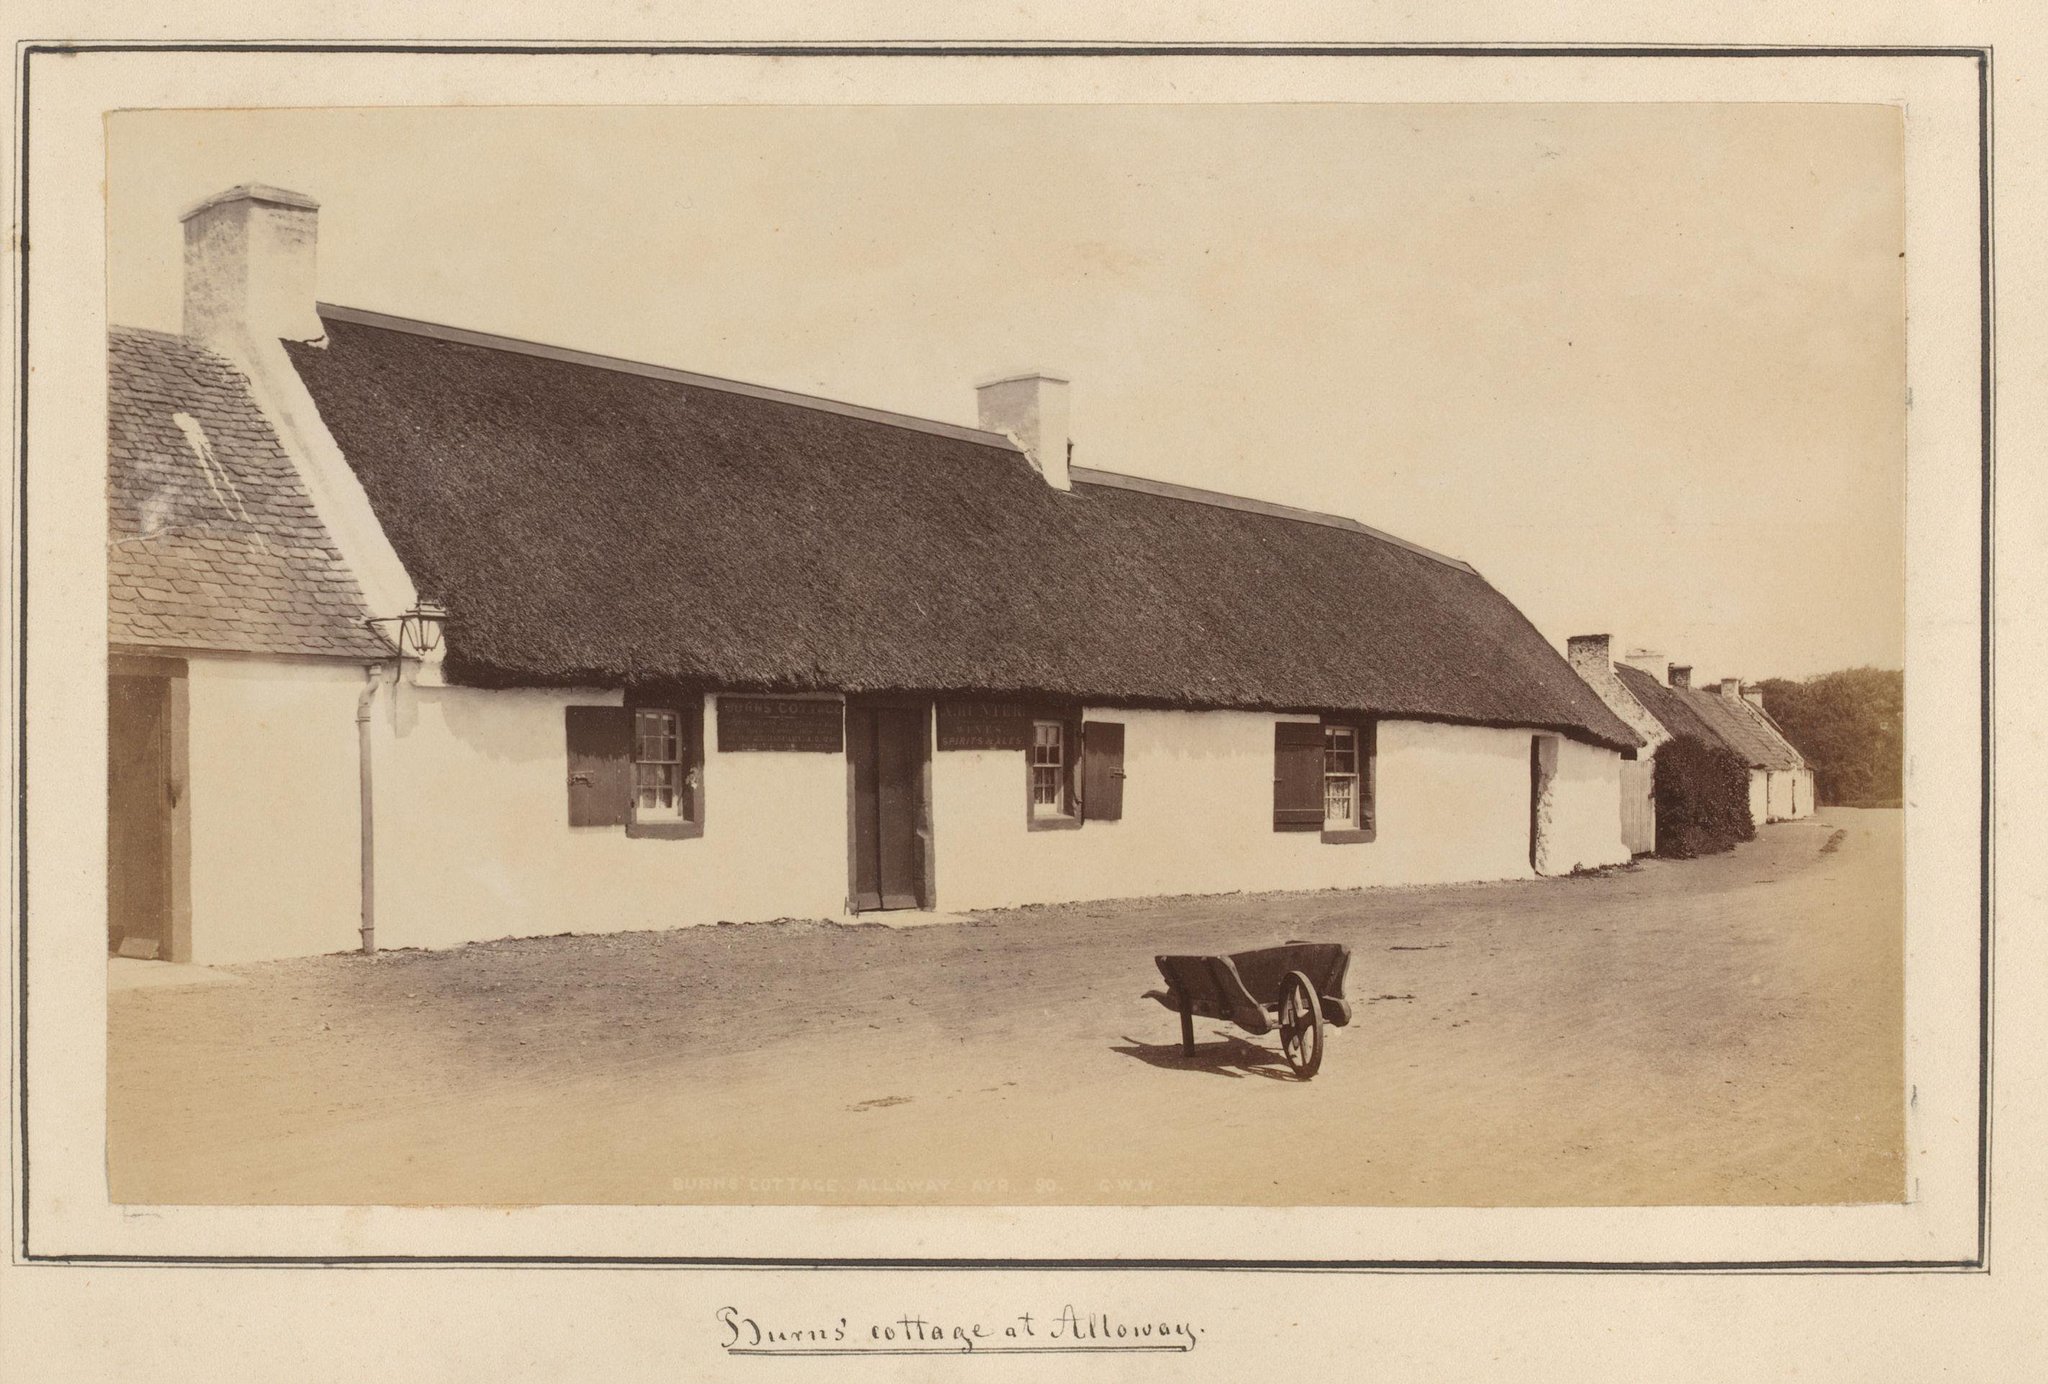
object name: photograph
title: Burns' Cottage at Alloway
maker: george washington wilson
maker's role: publisher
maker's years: 1823-1893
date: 1870-1890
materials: paper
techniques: albumen print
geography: alloway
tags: robert burns, cottage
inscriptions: inscription: ‘Burns' Cottage. Alloway. Ayr. 90. G.W.W.’